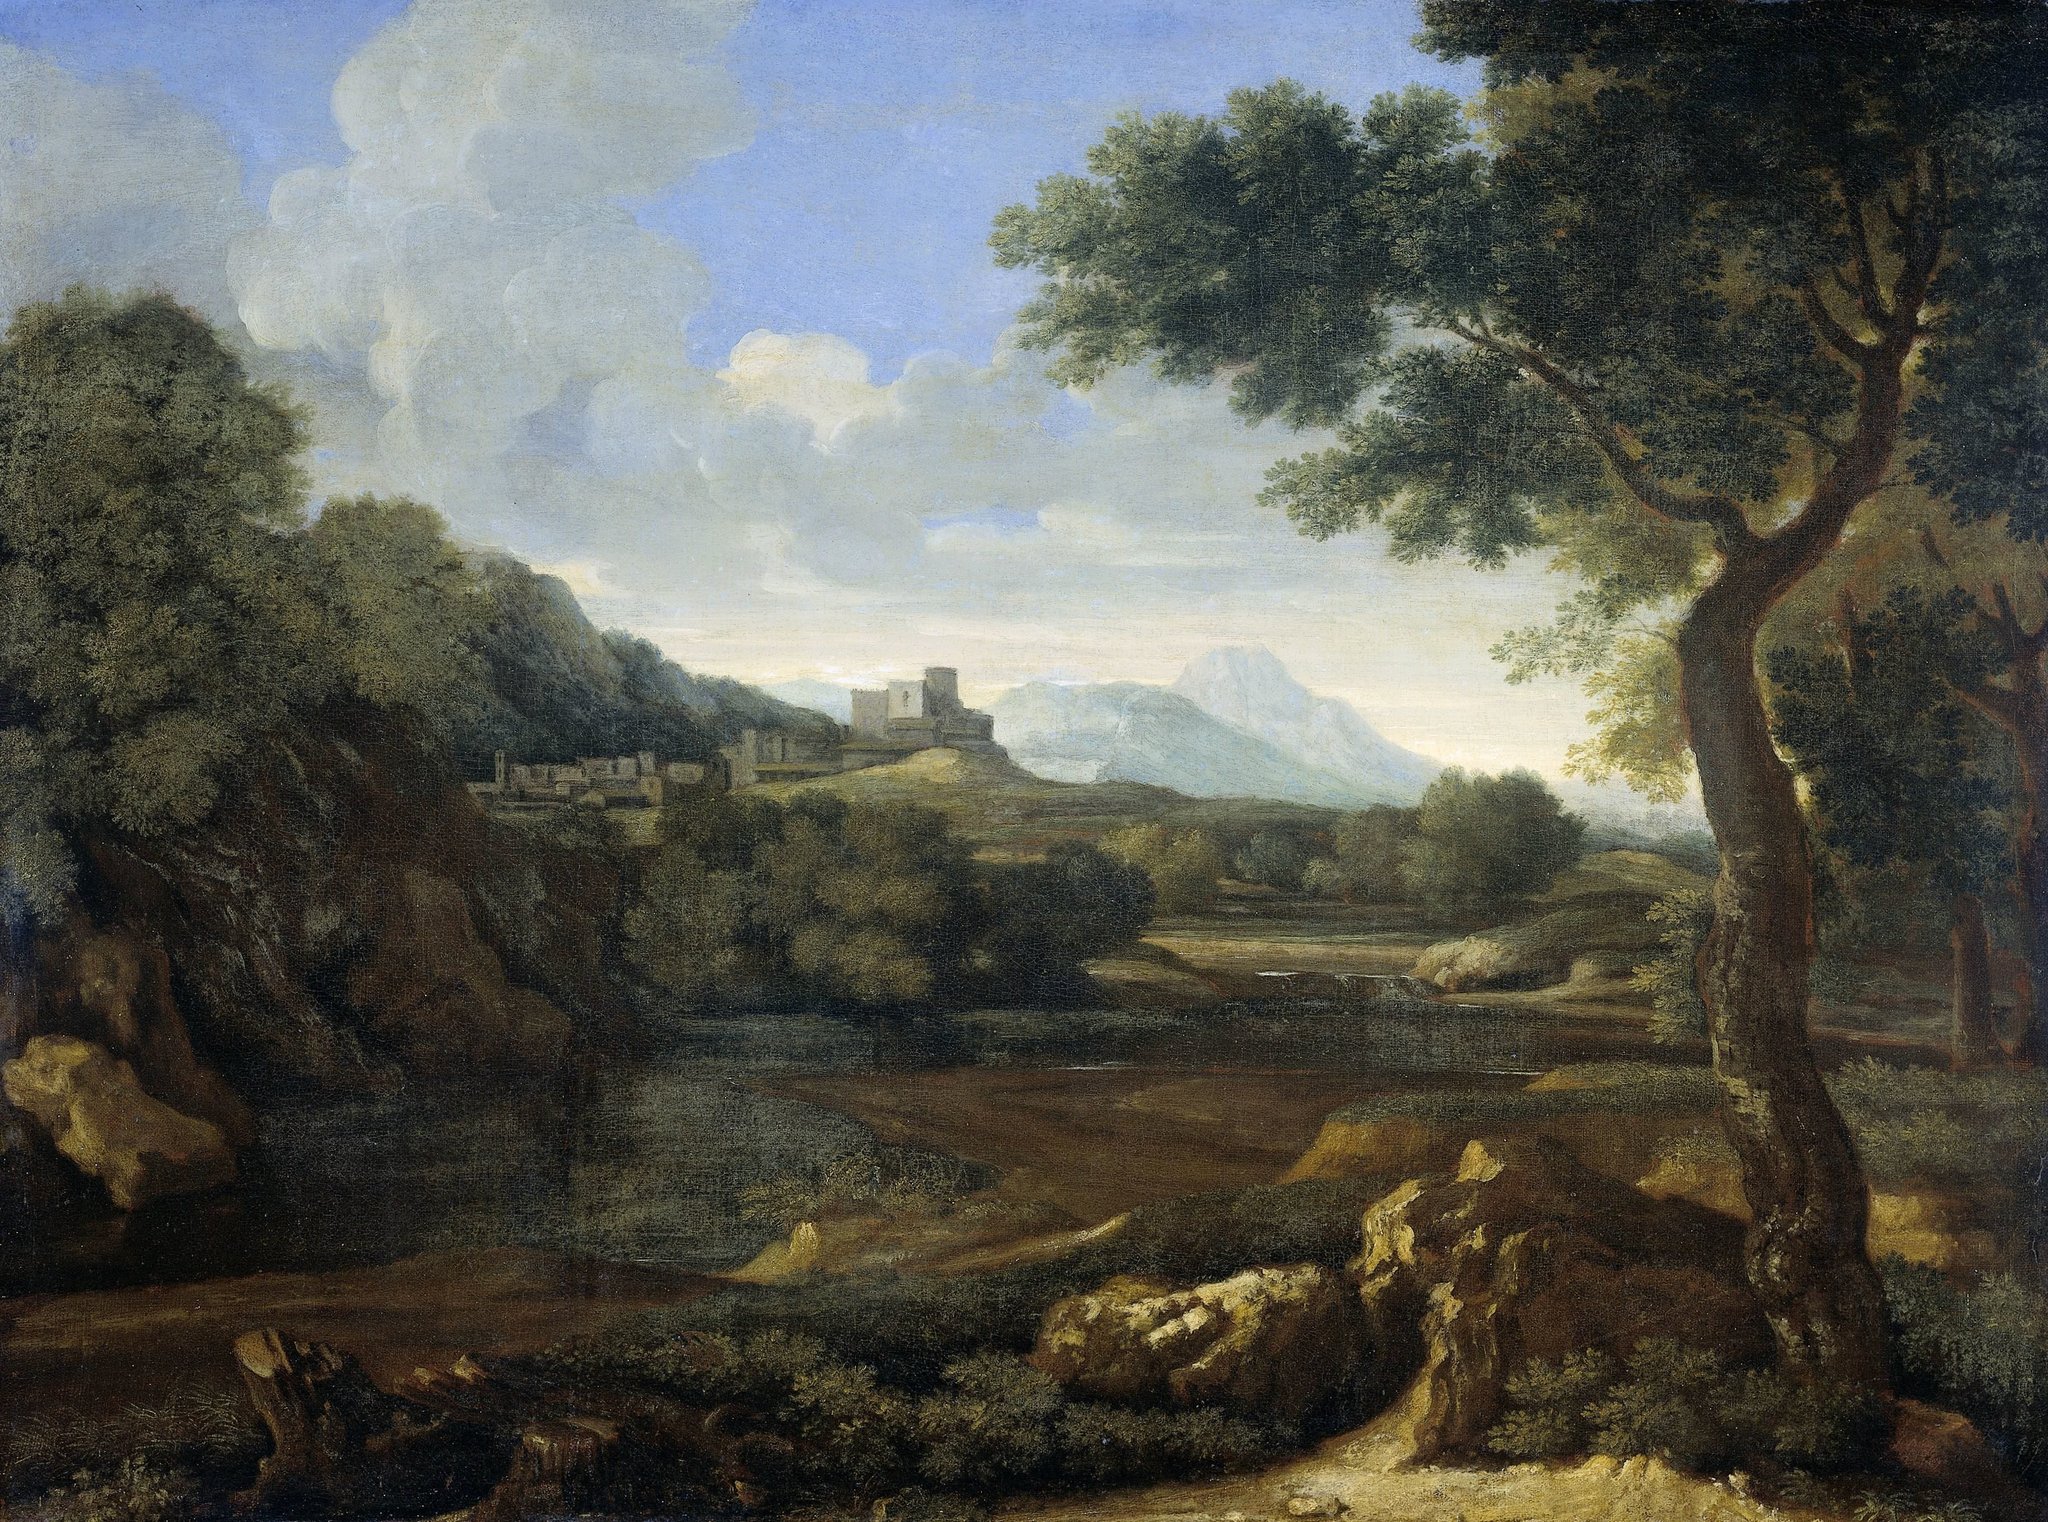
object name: painting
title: Landscape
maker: gaspard dughet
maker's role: draughtsman, painter, print maker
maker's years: 1615-1675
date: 1640-1645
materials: canvas, oil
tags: (high) hill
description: Heuvelachtig landschap. Links een dorp op een plateau.